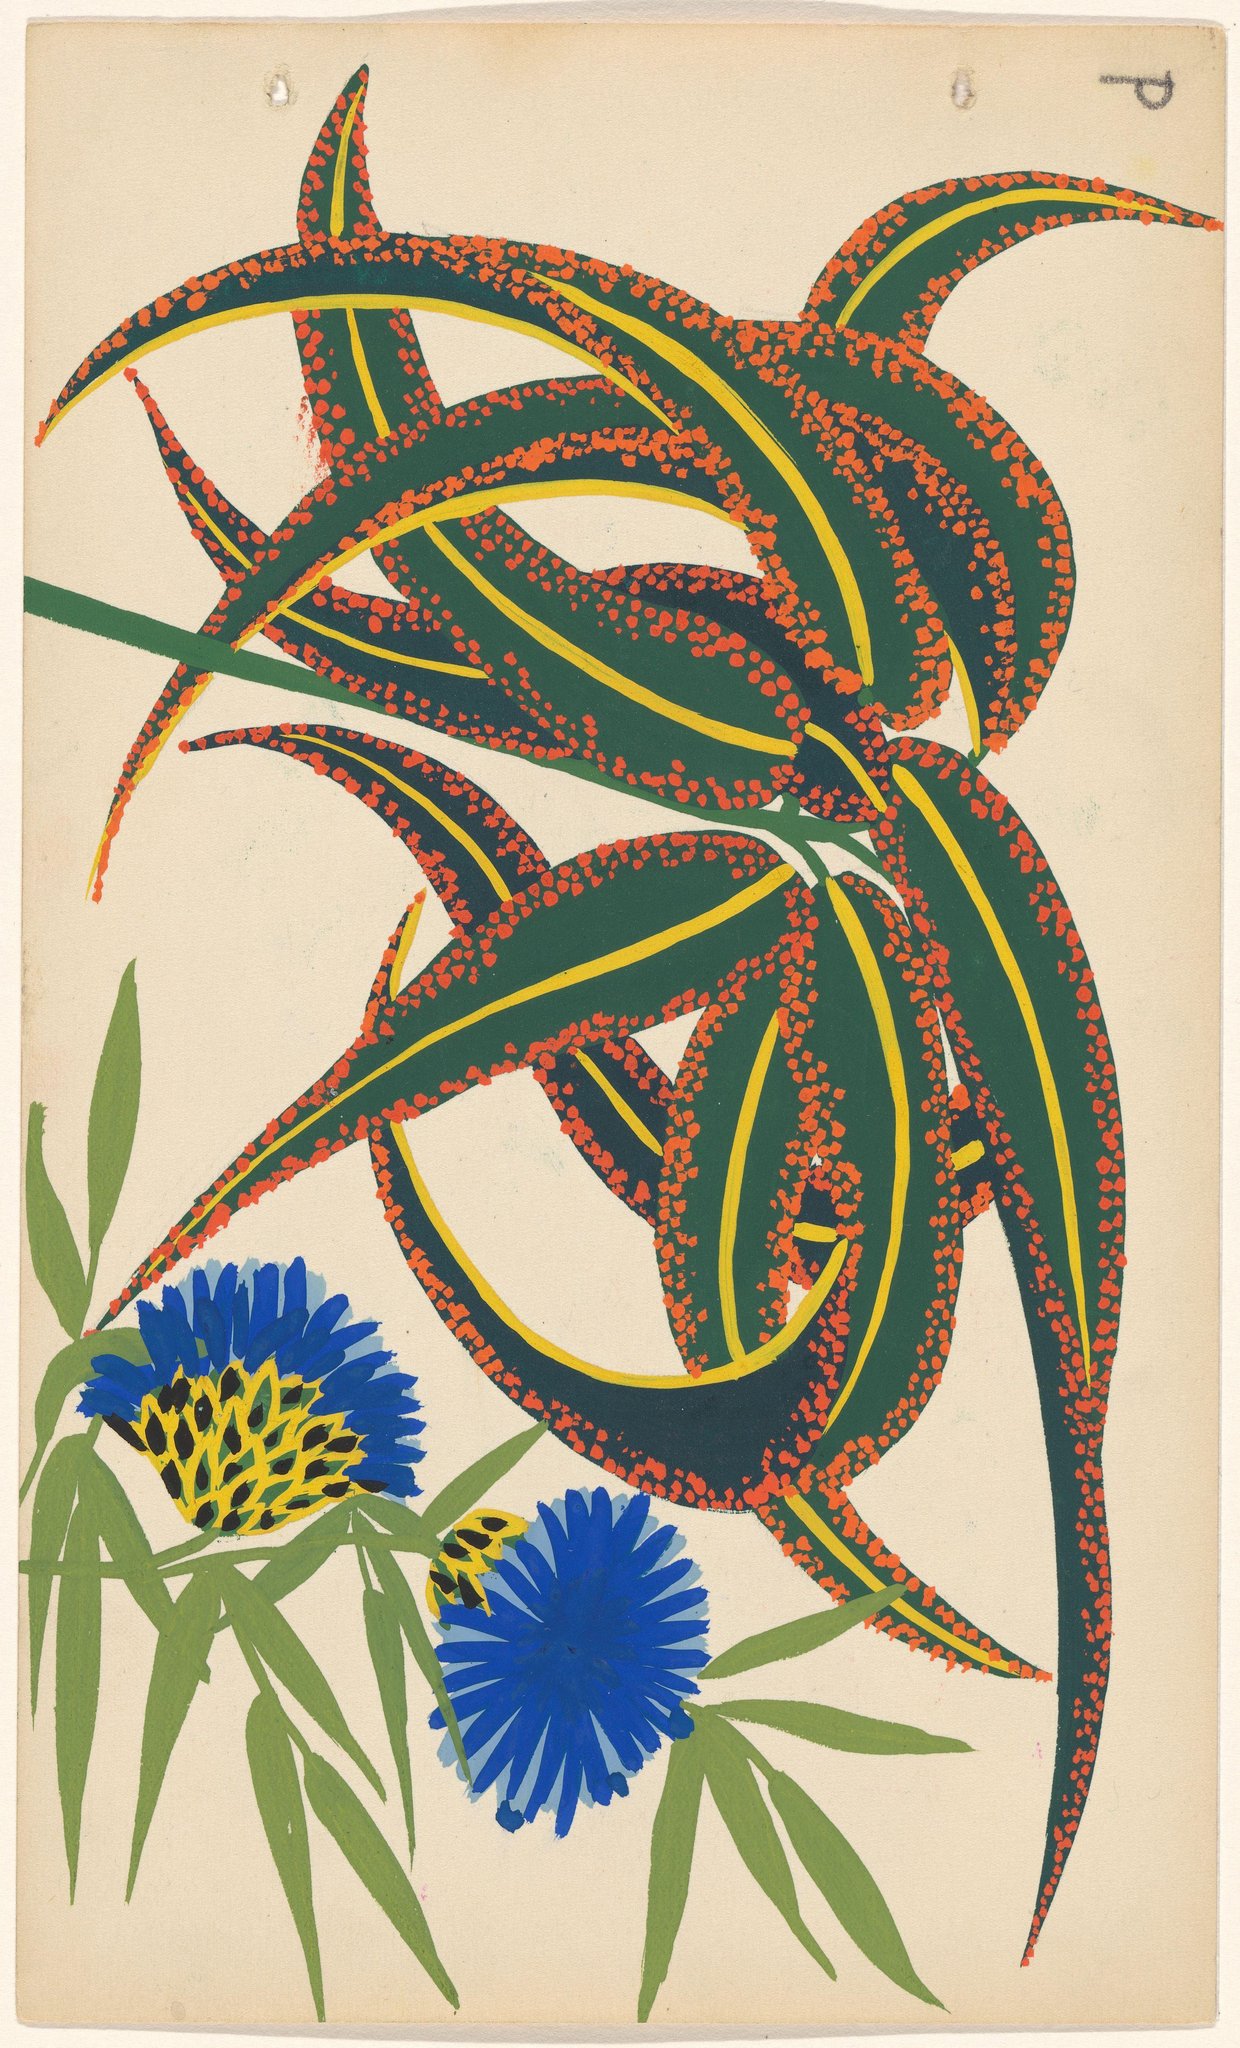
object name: design drawing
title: Ontwerp voor borduurwerk van bloemen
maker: paul poiret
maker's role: couturier, modeontwerper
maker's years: 1879-1944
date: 1914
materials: gouache, paper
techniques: perforating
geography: paris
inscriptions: inscription, inscription: ‘P’